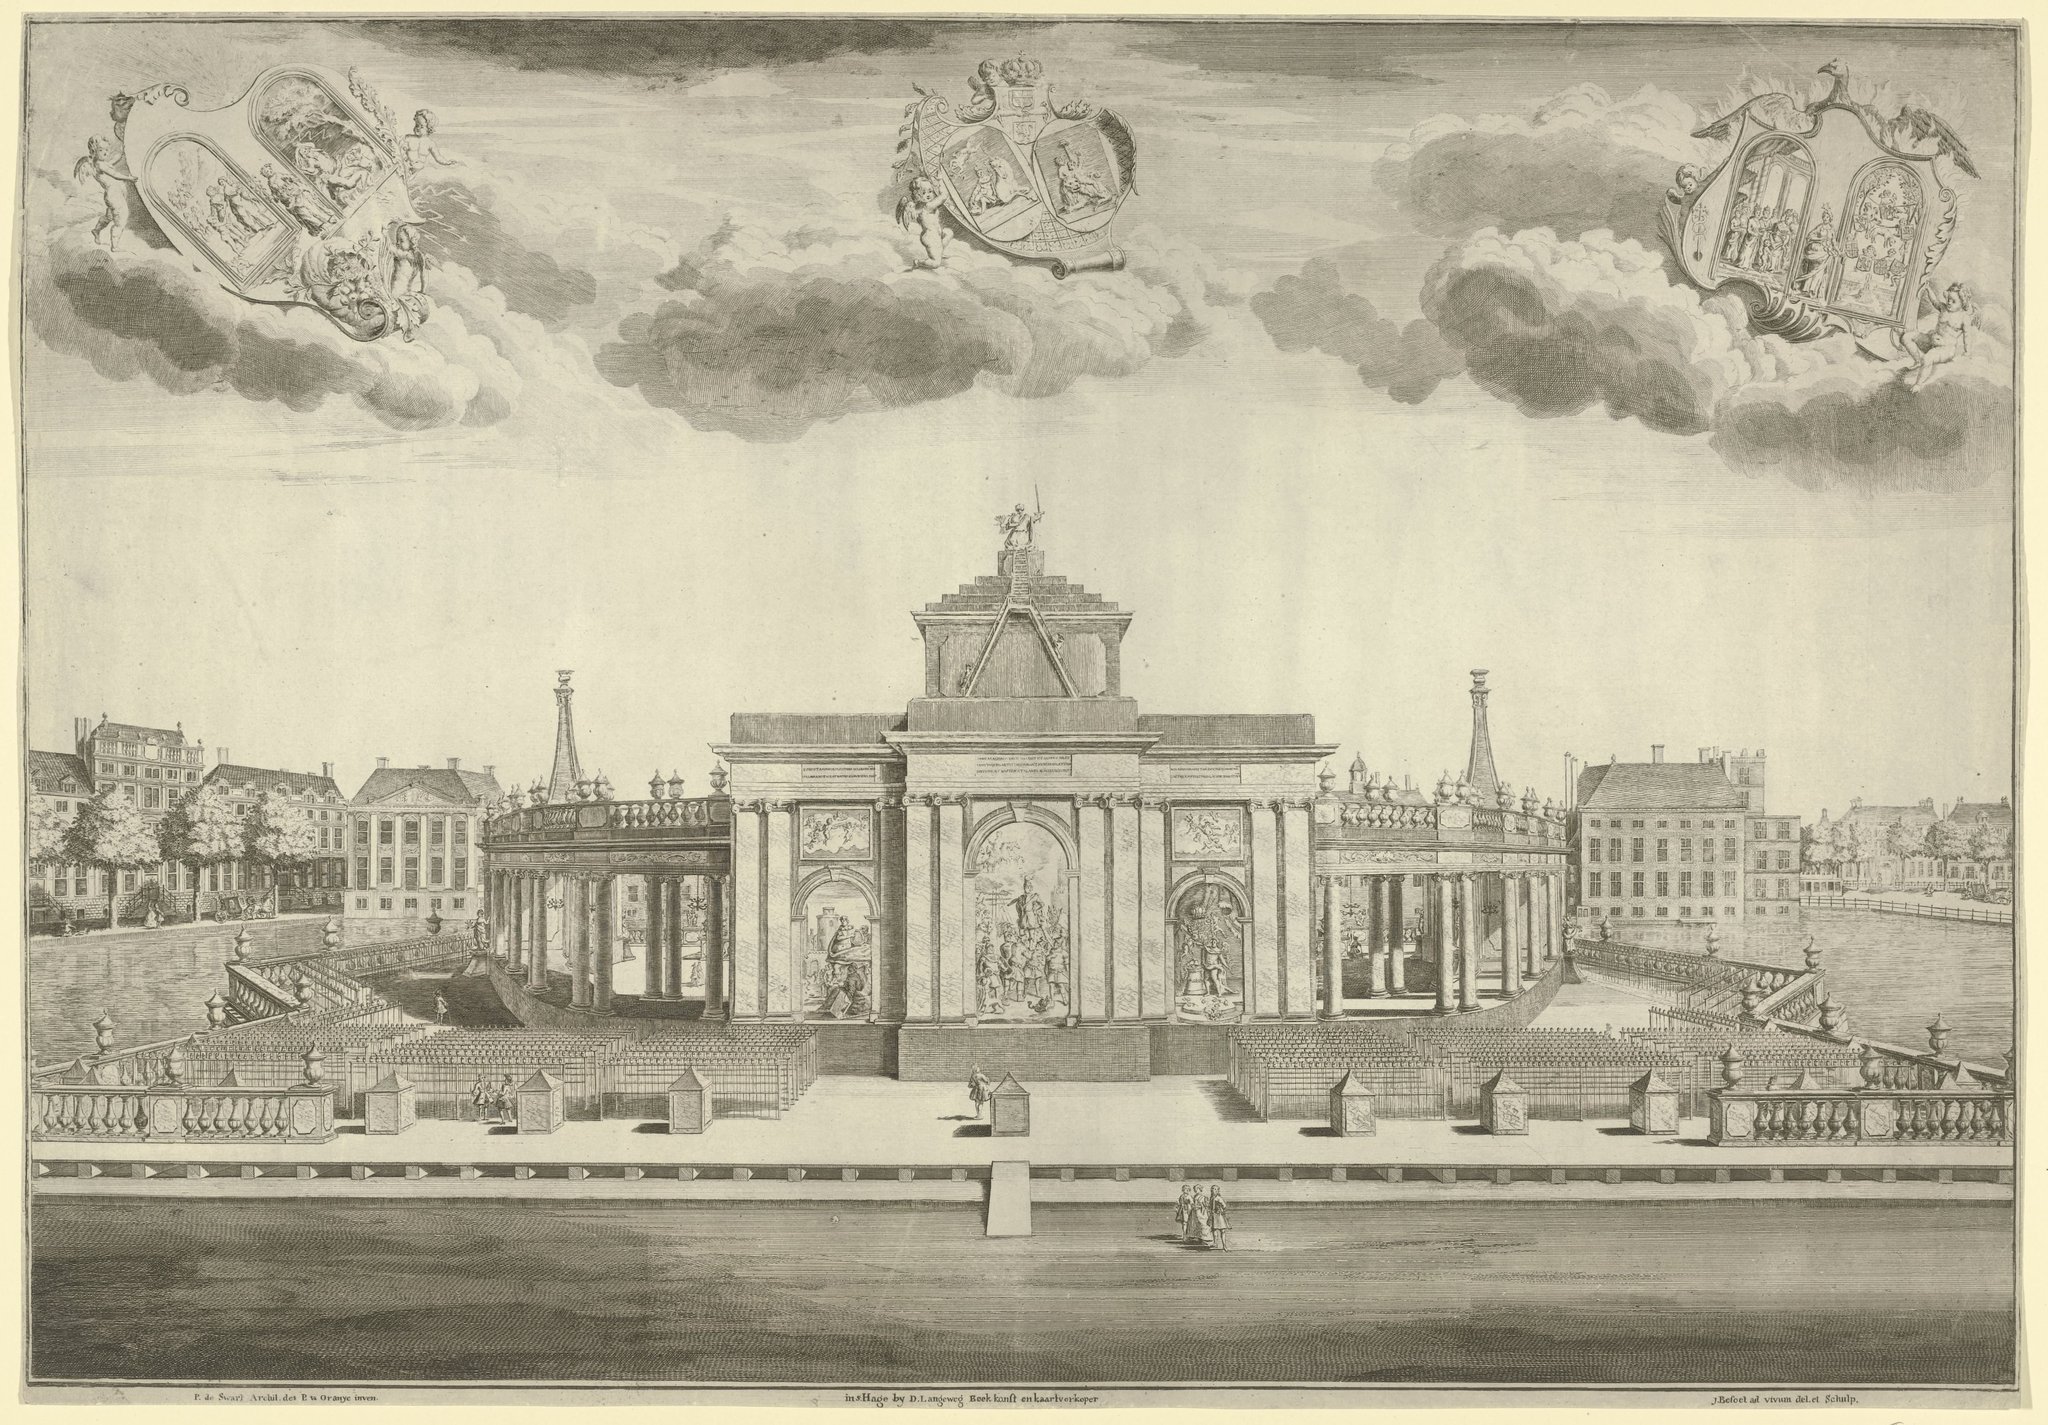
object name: print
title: Theater (achterzijde) te Den Haag voor het het vuurwerk voor de Vrede van Aken, 1749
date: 1749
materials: paper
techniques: engraving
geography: northern netherlands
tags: plan ~ architecture, bonfire, fire-works (+ illumination, fire-works ~ festive activities)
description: Het grote theater (achterzijde) opgericht in de Hofvijver te Den Haag dat op 11 juni geïllumineerd is geweest en op 13 juni 1749 gebruikt is voor het vuurwerk ter ere van de Vrede van Aken gesloten in 1748. Op de achtergrond rechts het Prinsenhof, links het Mauritshuis. In de wolken panelen met de allegorische voorstellingen die te zien waren op de chassinetten aan de andere zijde van het theater. Bij de prent behoort een tekstblad met een beschrijving van het theater.